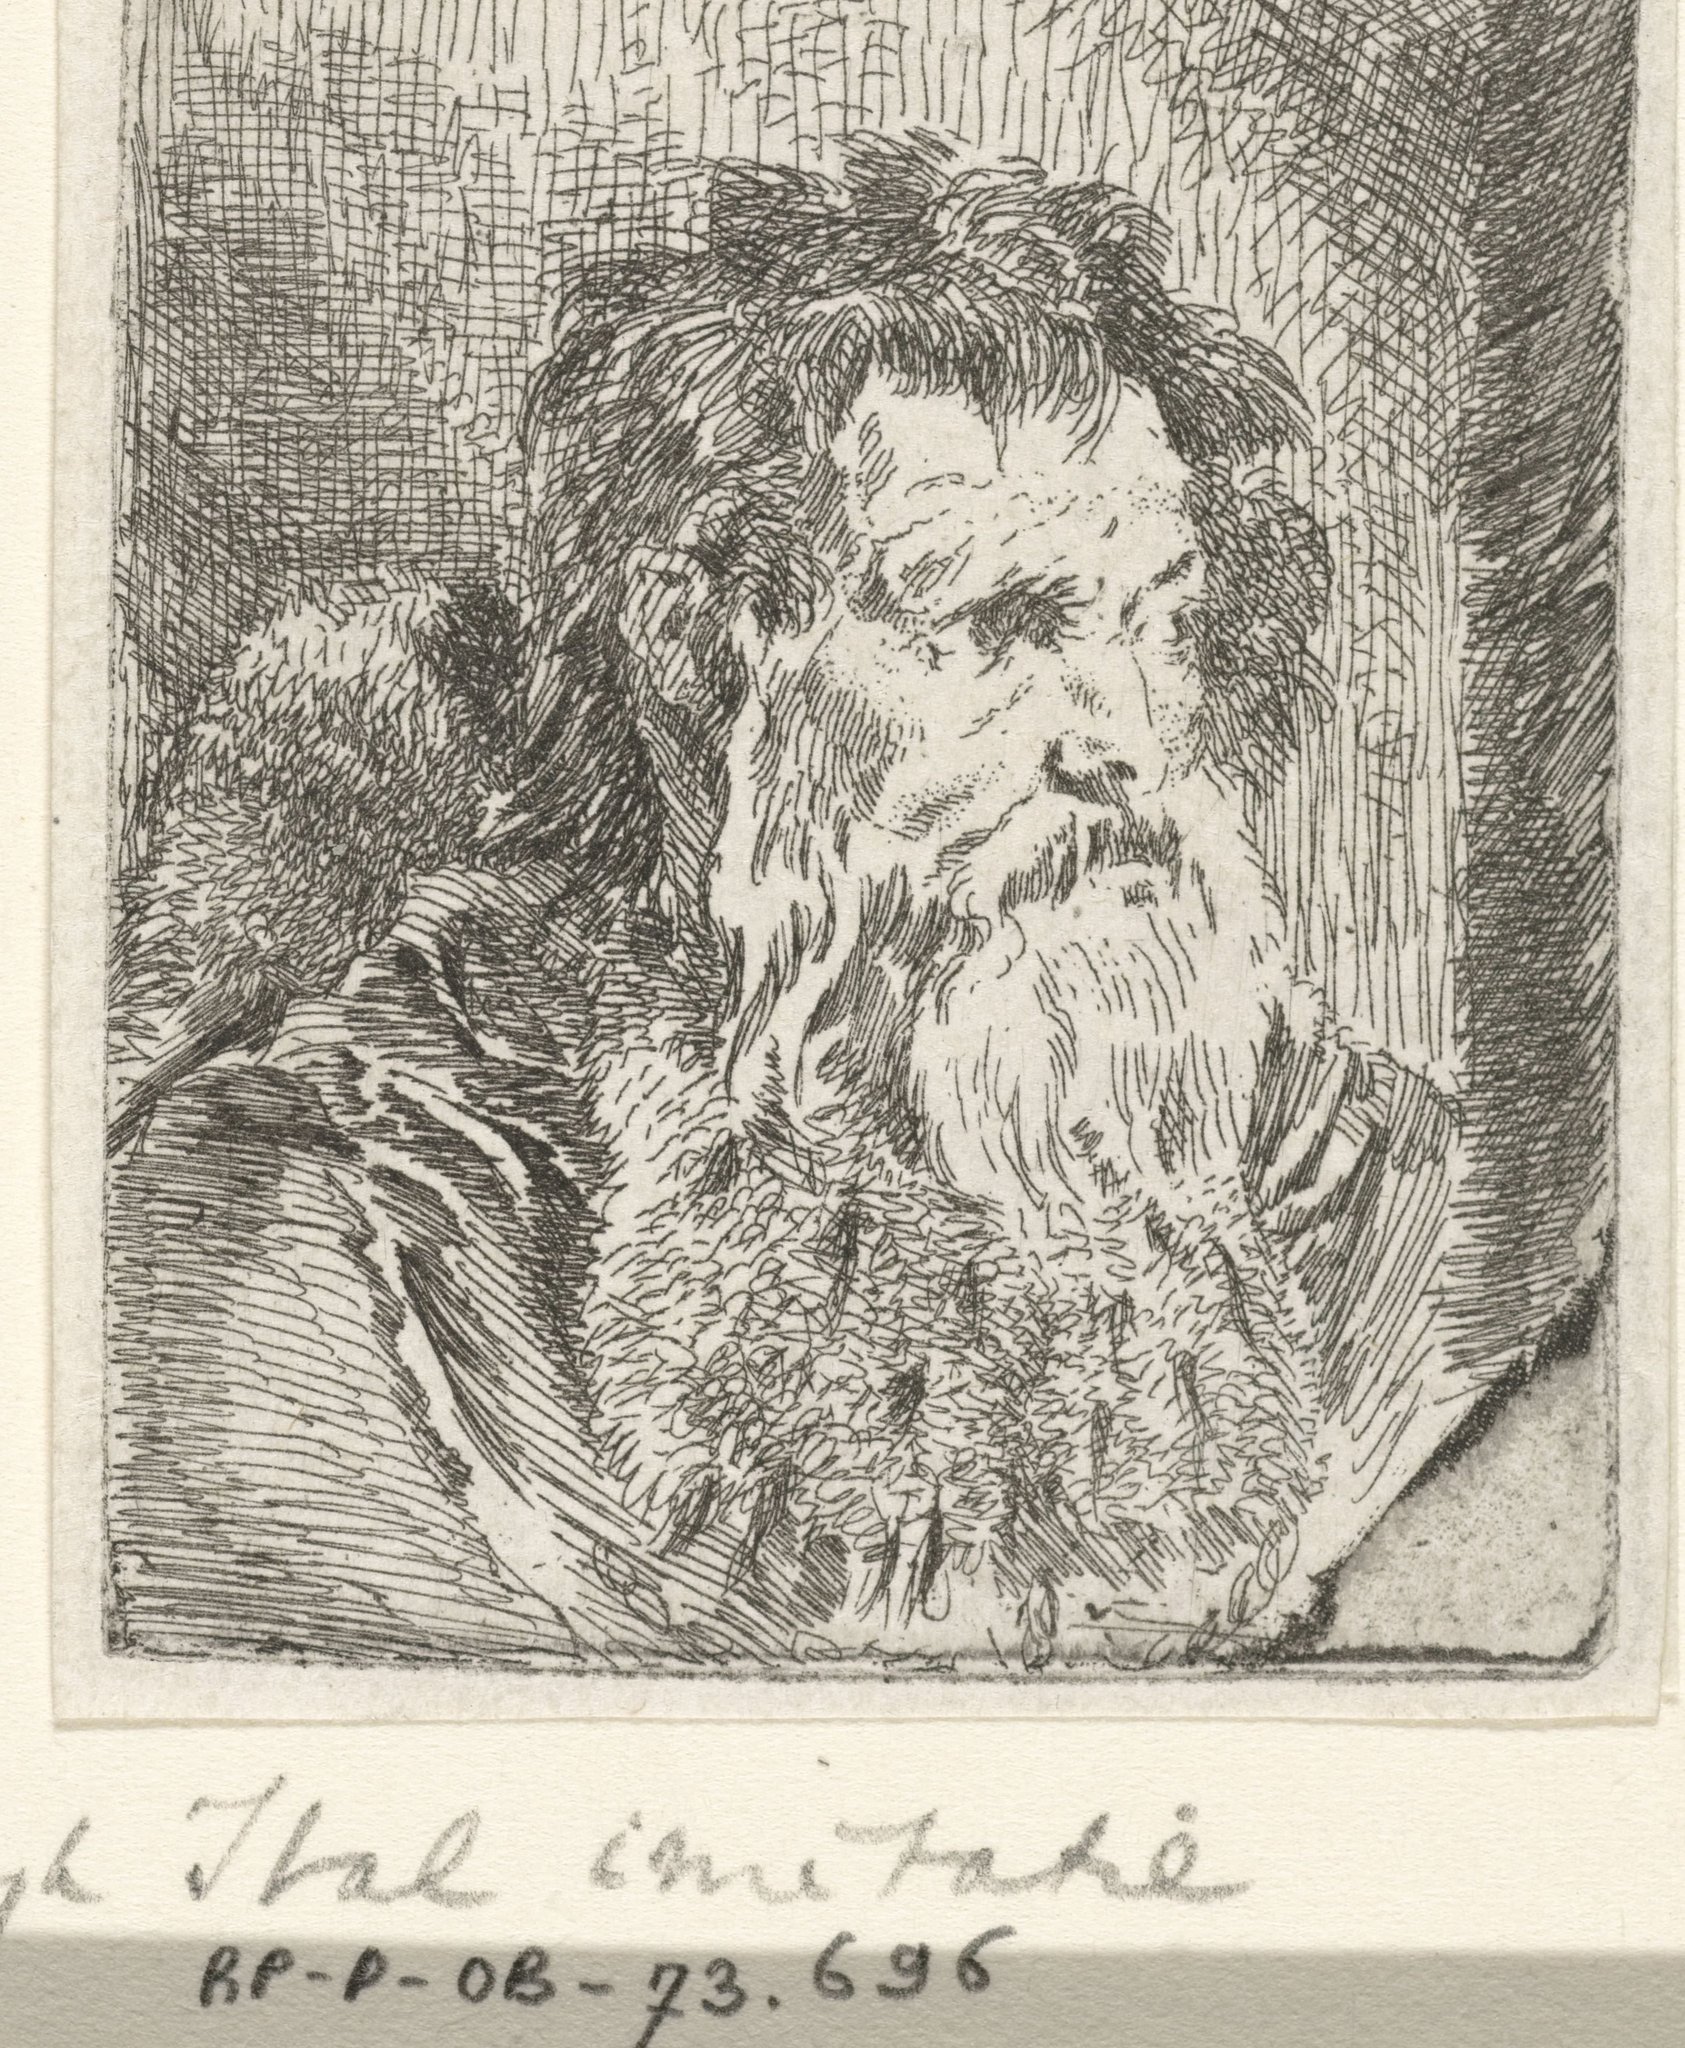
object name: print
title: Buste van oude man met baard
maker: jacques-philippe le bas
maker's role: draughtsman, print maker, publisher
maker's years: 1707-1783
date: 1616-1719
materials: paper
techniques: etching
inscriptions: collector's mark: Lugt 323, collector's mark: Lugt 240